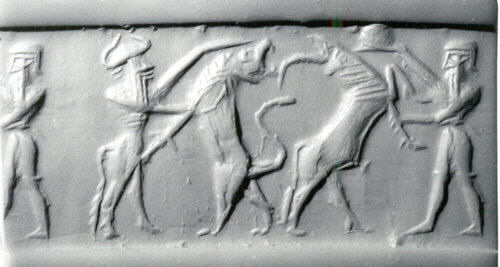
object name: cylinder seal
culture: akkadian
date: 2350-2150 BCE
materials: mineral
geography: mesopotamia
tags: animals